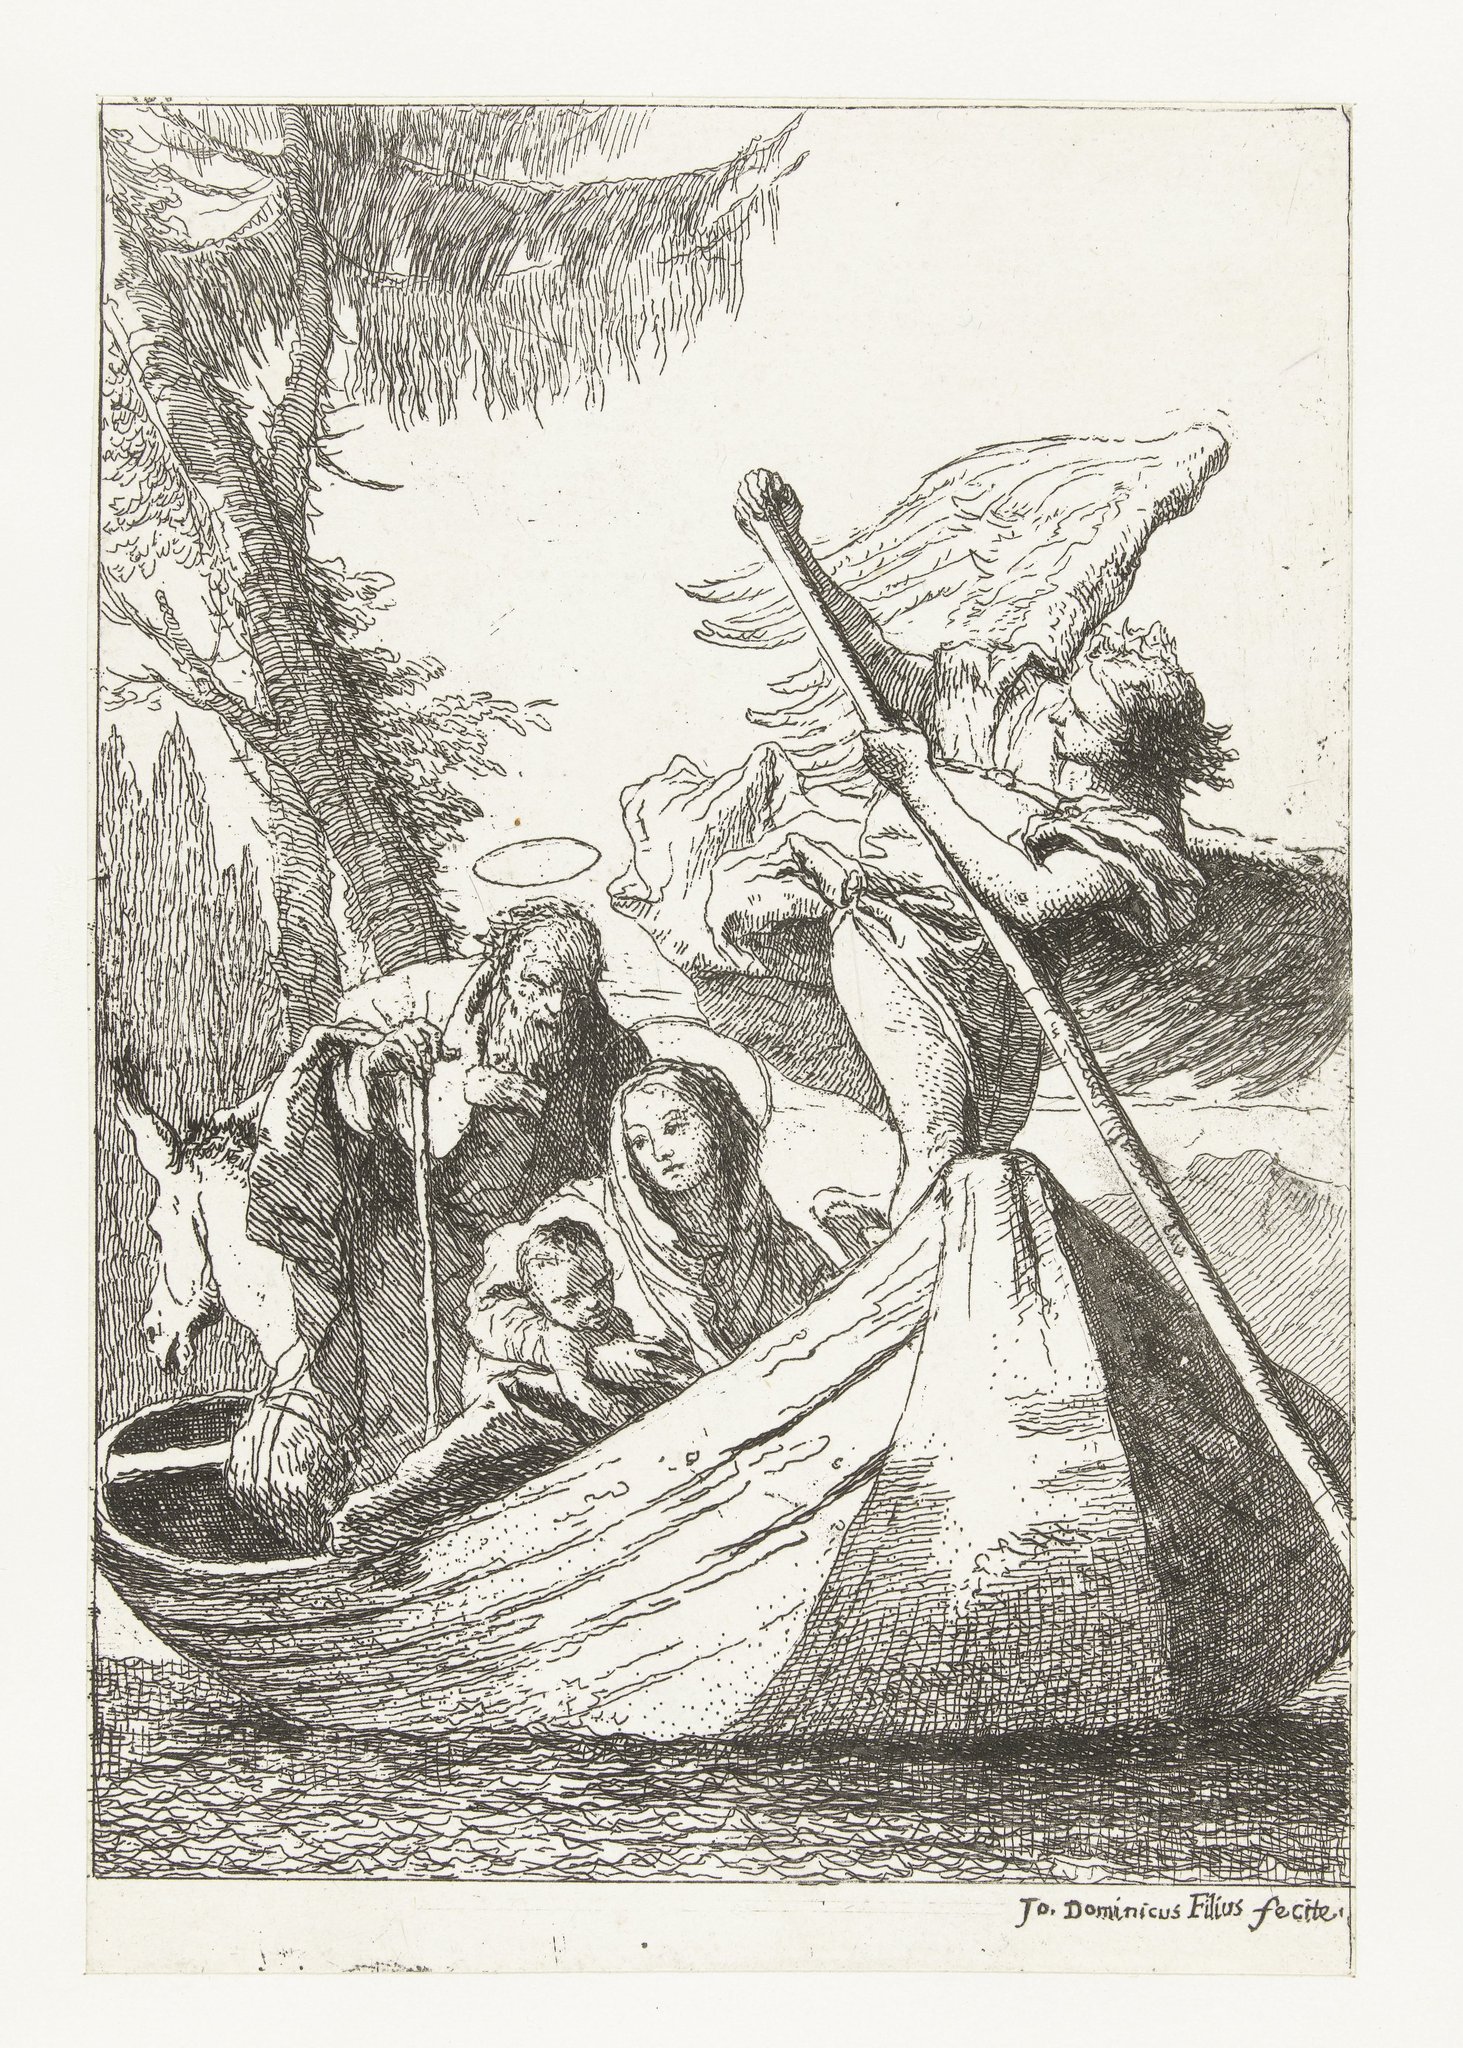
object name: print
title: Heilige familie in boot met engel als bootsman tijdens vlucht naar Egypte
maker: giovanni domenico tiepolo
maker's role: draughtsman, print maker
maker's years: 1727-1804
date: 1748-1752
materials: paper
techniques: etching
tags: flight into egypt and miracles during the journey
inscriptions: collector's mark: Lugt 2228, collector's mark: Lugt 2760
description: Prent naar ontwerp van Giovanni Battista Tiepolo. Prent maakt deel uit van blad met twee scènes uit het bijbelverhaal van de Vlucht naar Egypte. In de collectie van het RMA zijn de twee prenten losgesneden (vergelijk inv.nr. RP-P-1950-490).